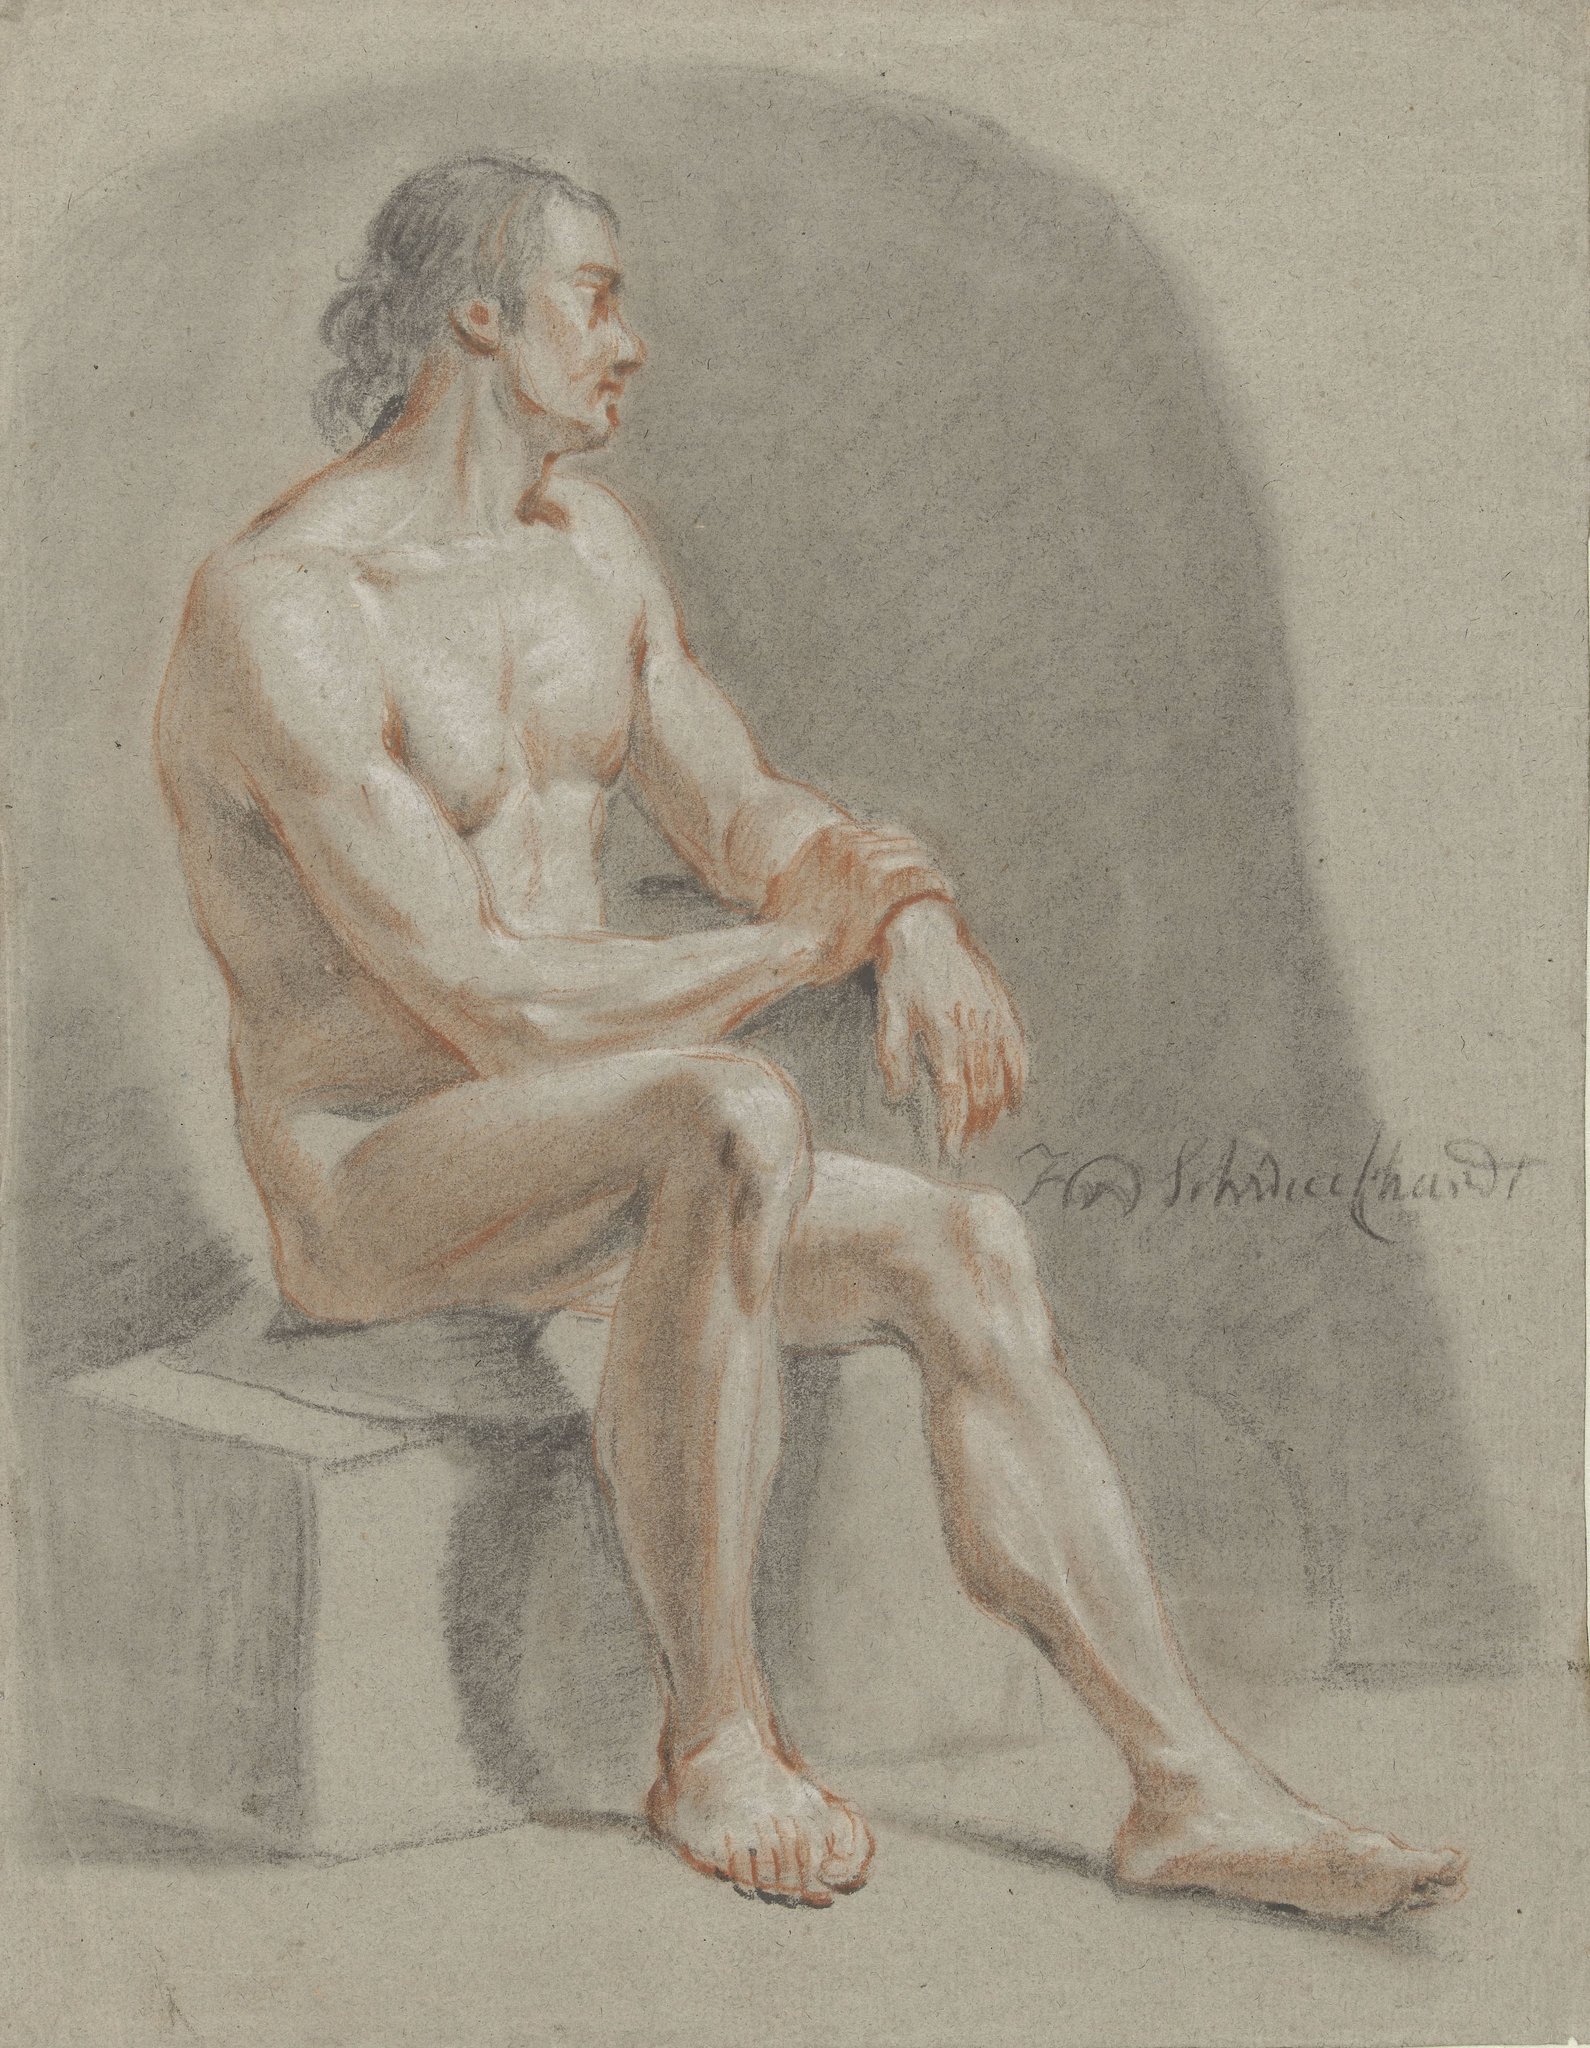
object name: drawing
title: Mannelijk naakt, zittend, naar rechts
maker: hendrik willem schweickhardt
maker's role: draughtsman, painter, print maker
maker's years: 1746-1797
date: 1756-1797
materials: chalk, paper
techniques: brush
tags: sitting figure